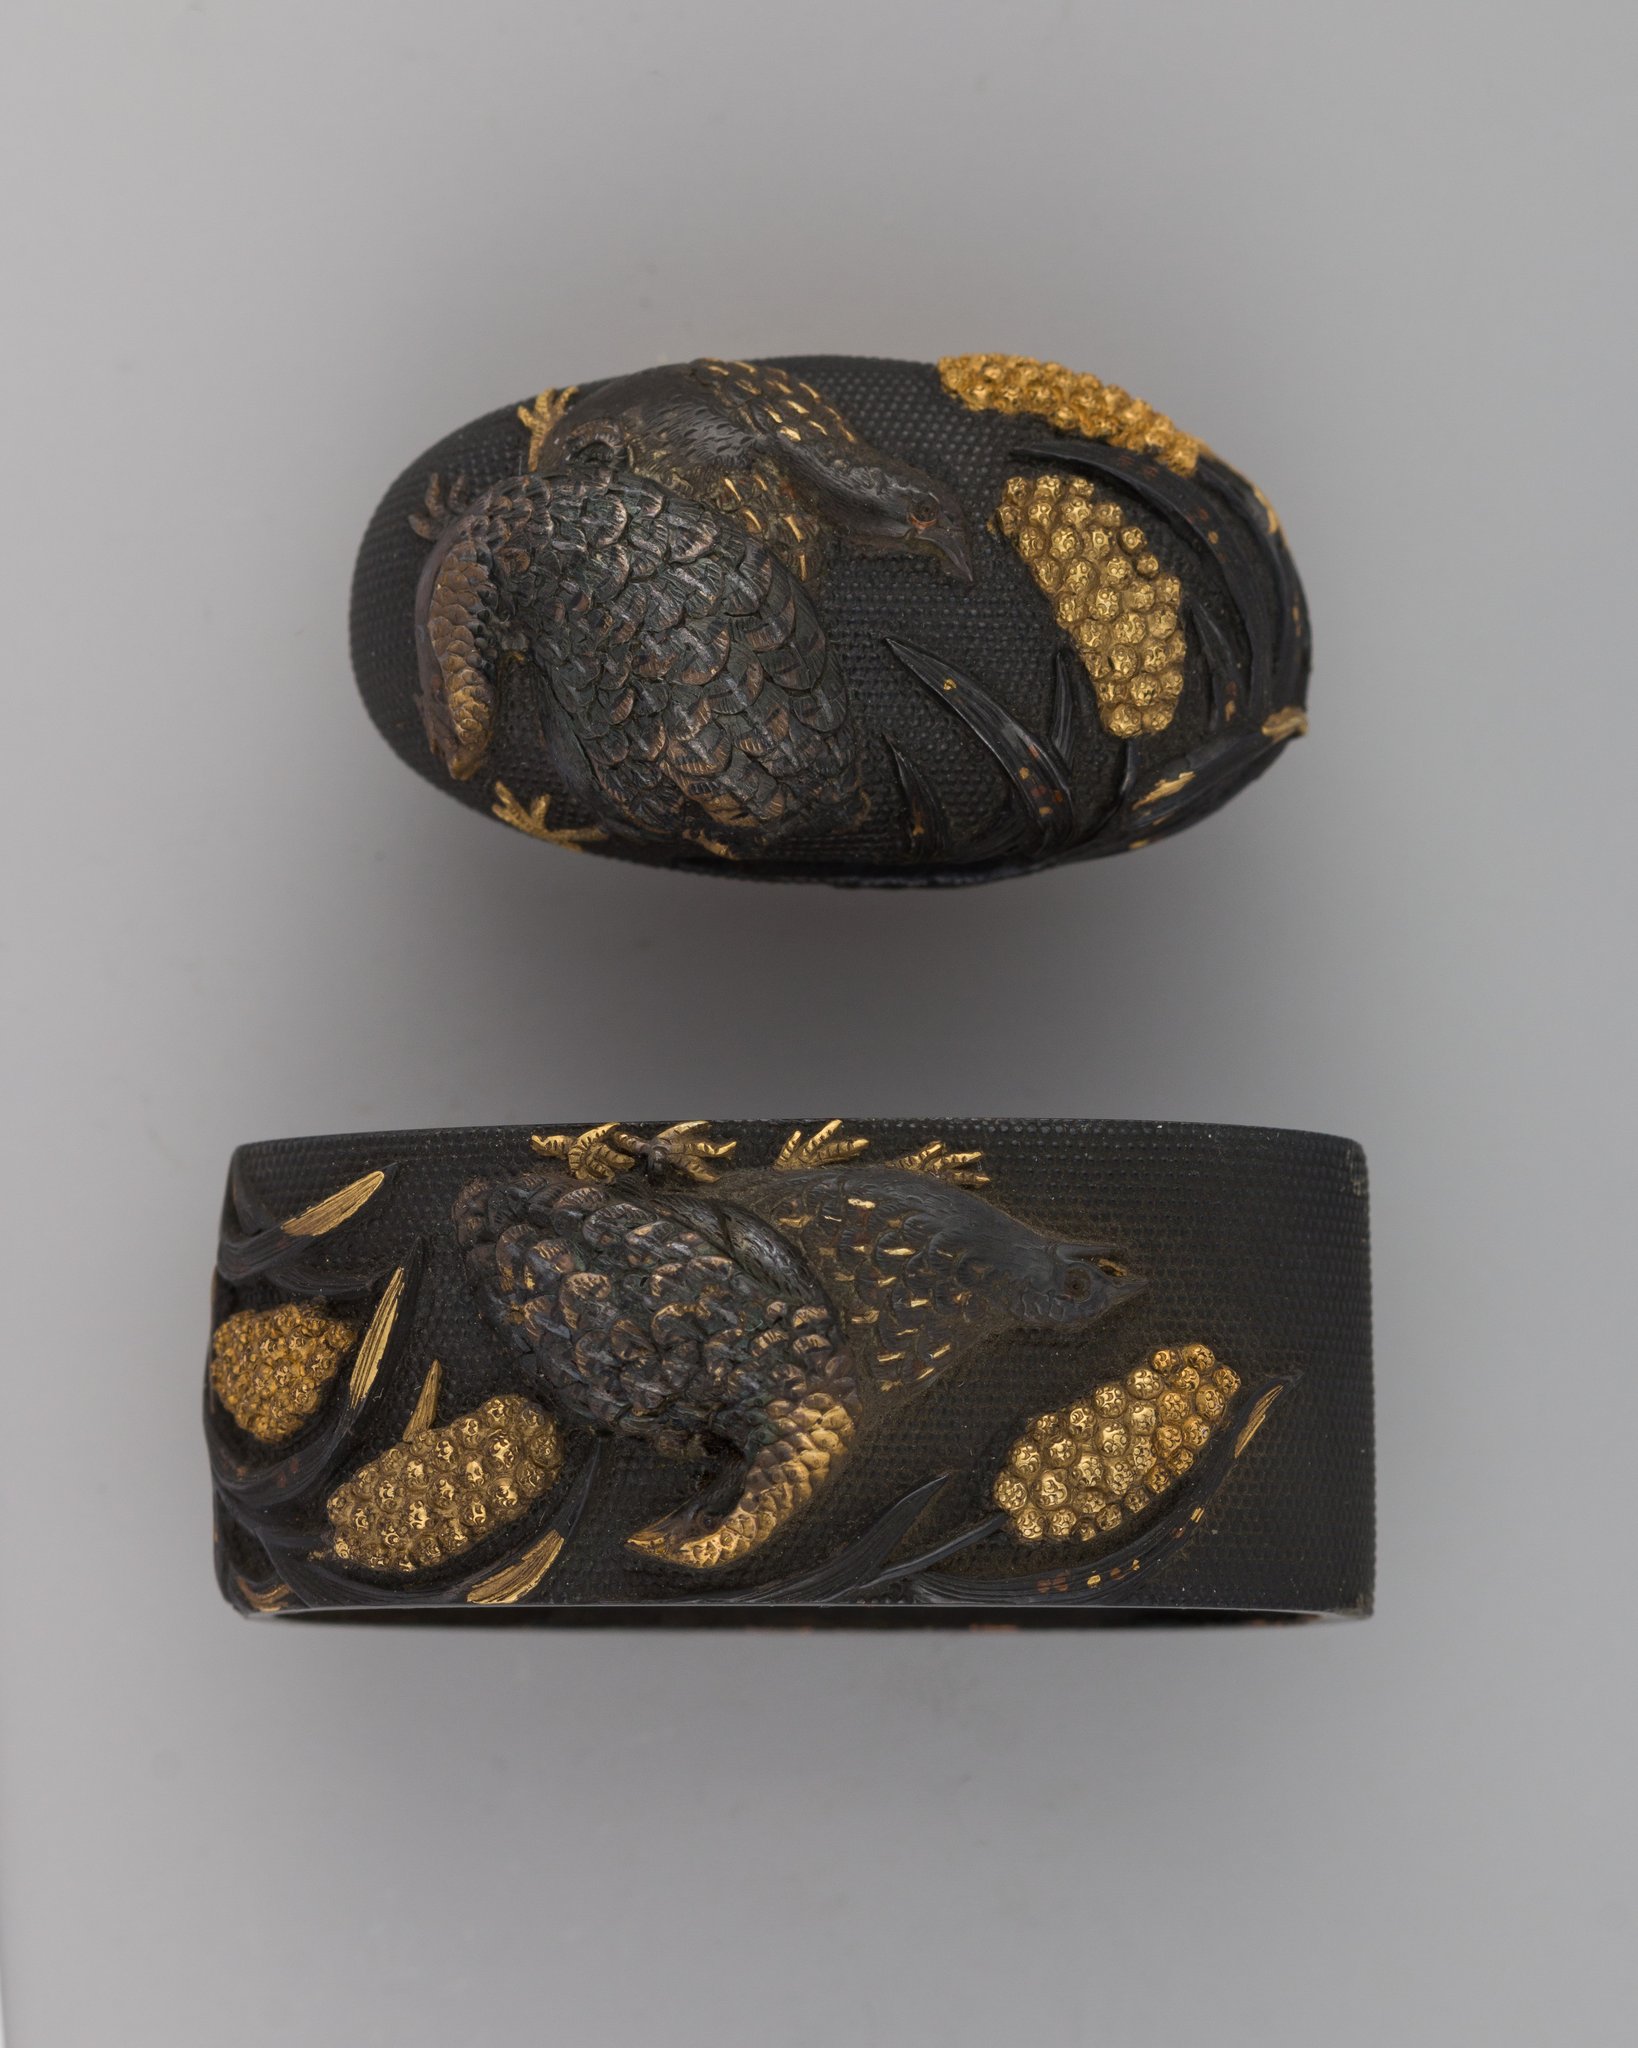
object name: sword hilt collar and pommel fuchigashira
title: Sword-Hilt Collar and Pommel (Fuchigashira)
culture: japanese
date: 1615-1868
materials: gold alloy, gold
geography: japan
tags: birds